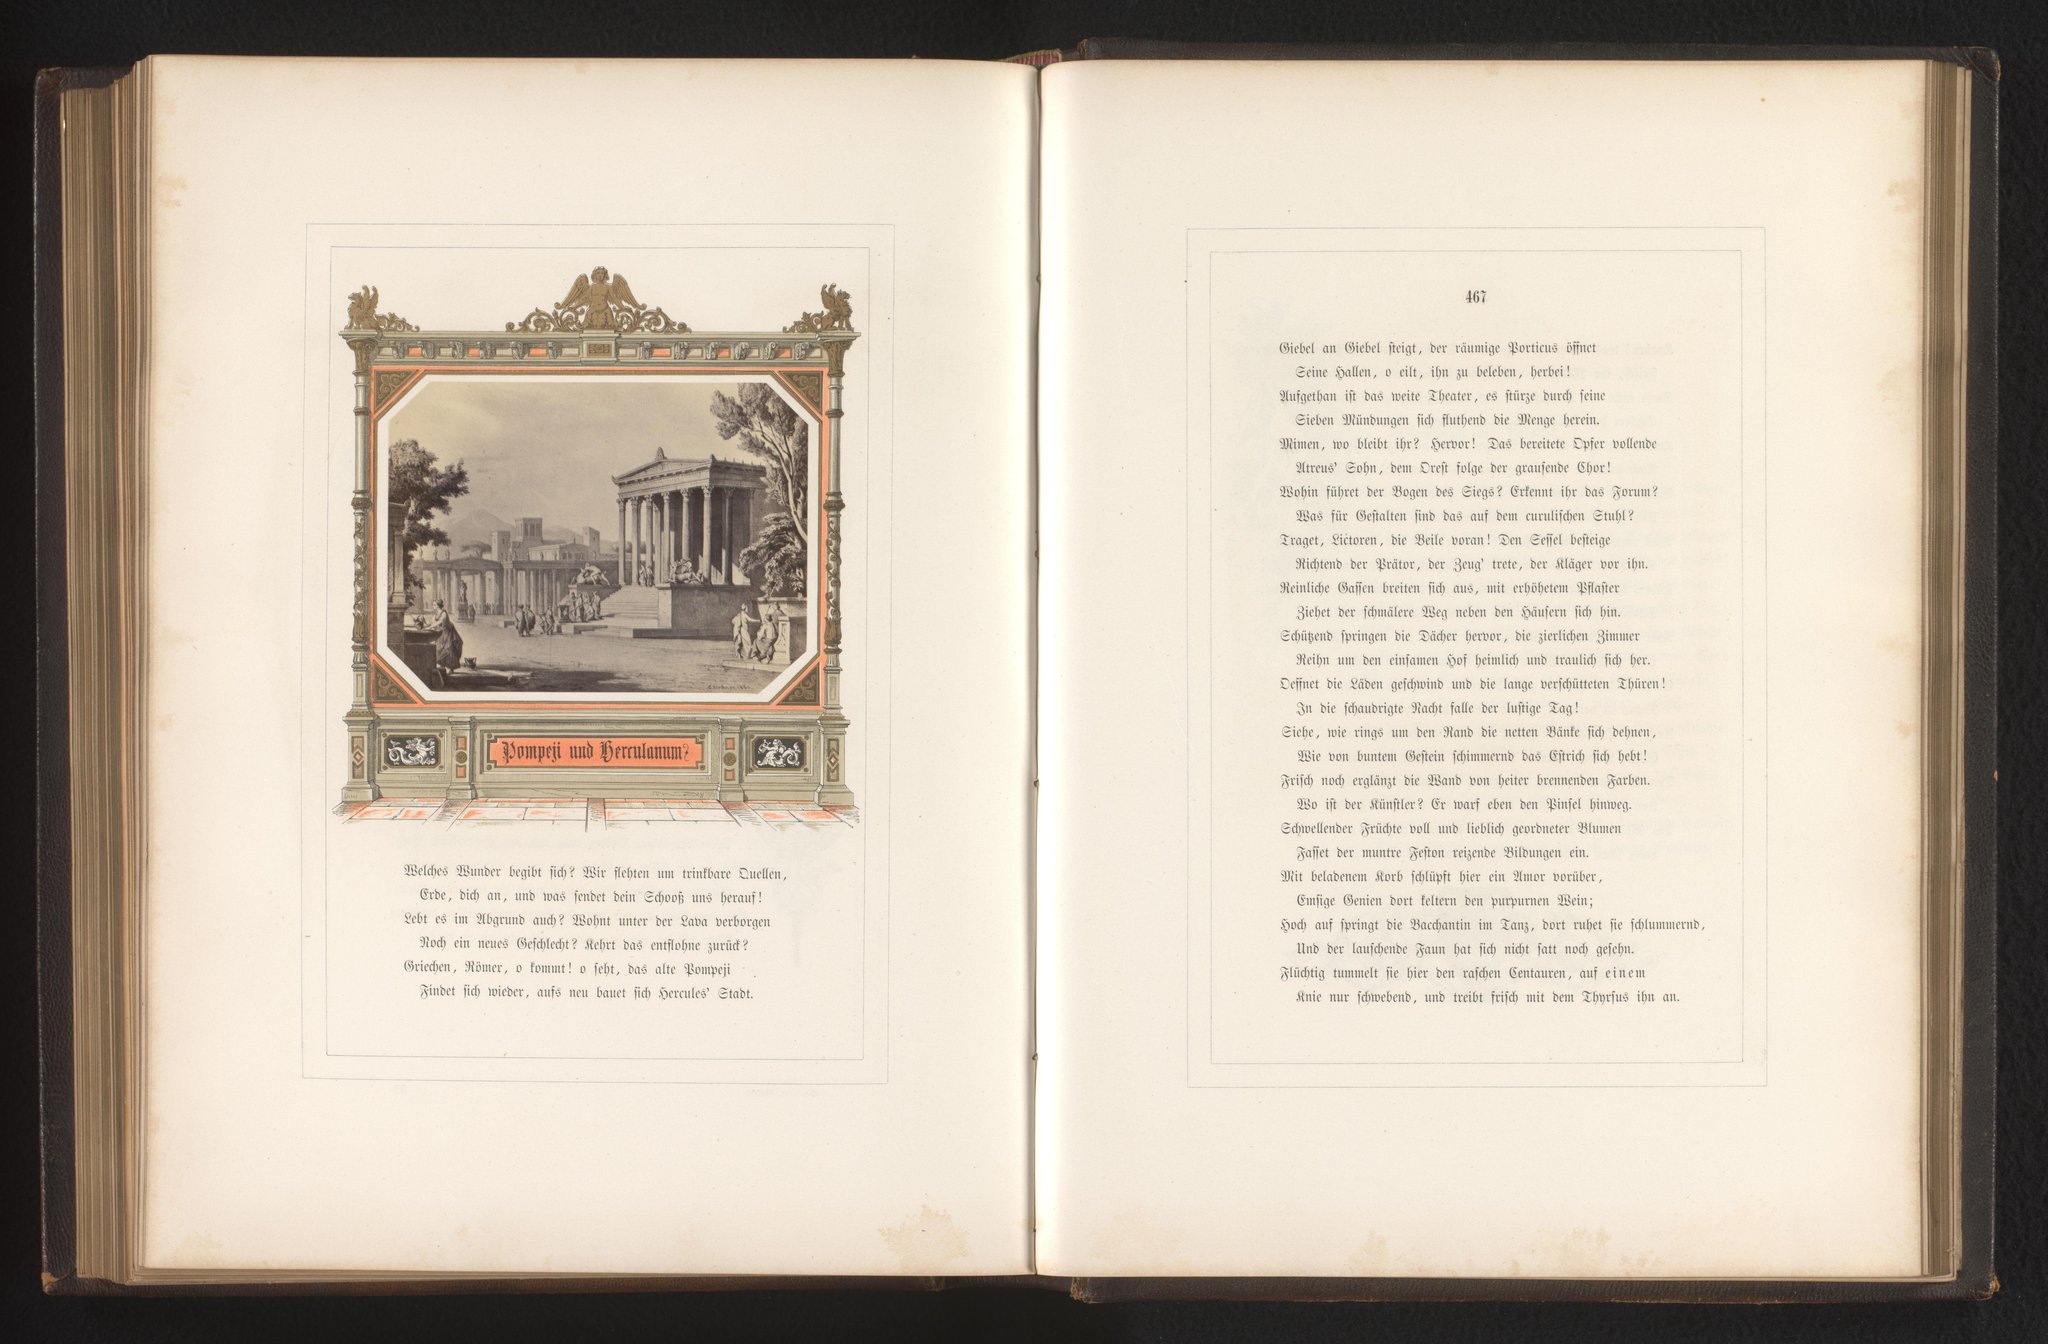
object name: reproduction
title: Kirchner: Pompeji und Herculanum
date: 1855-1862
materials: paper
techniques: albumen print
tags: square, place, circus, etc., temple, shrine ~ roman religion, pompeii